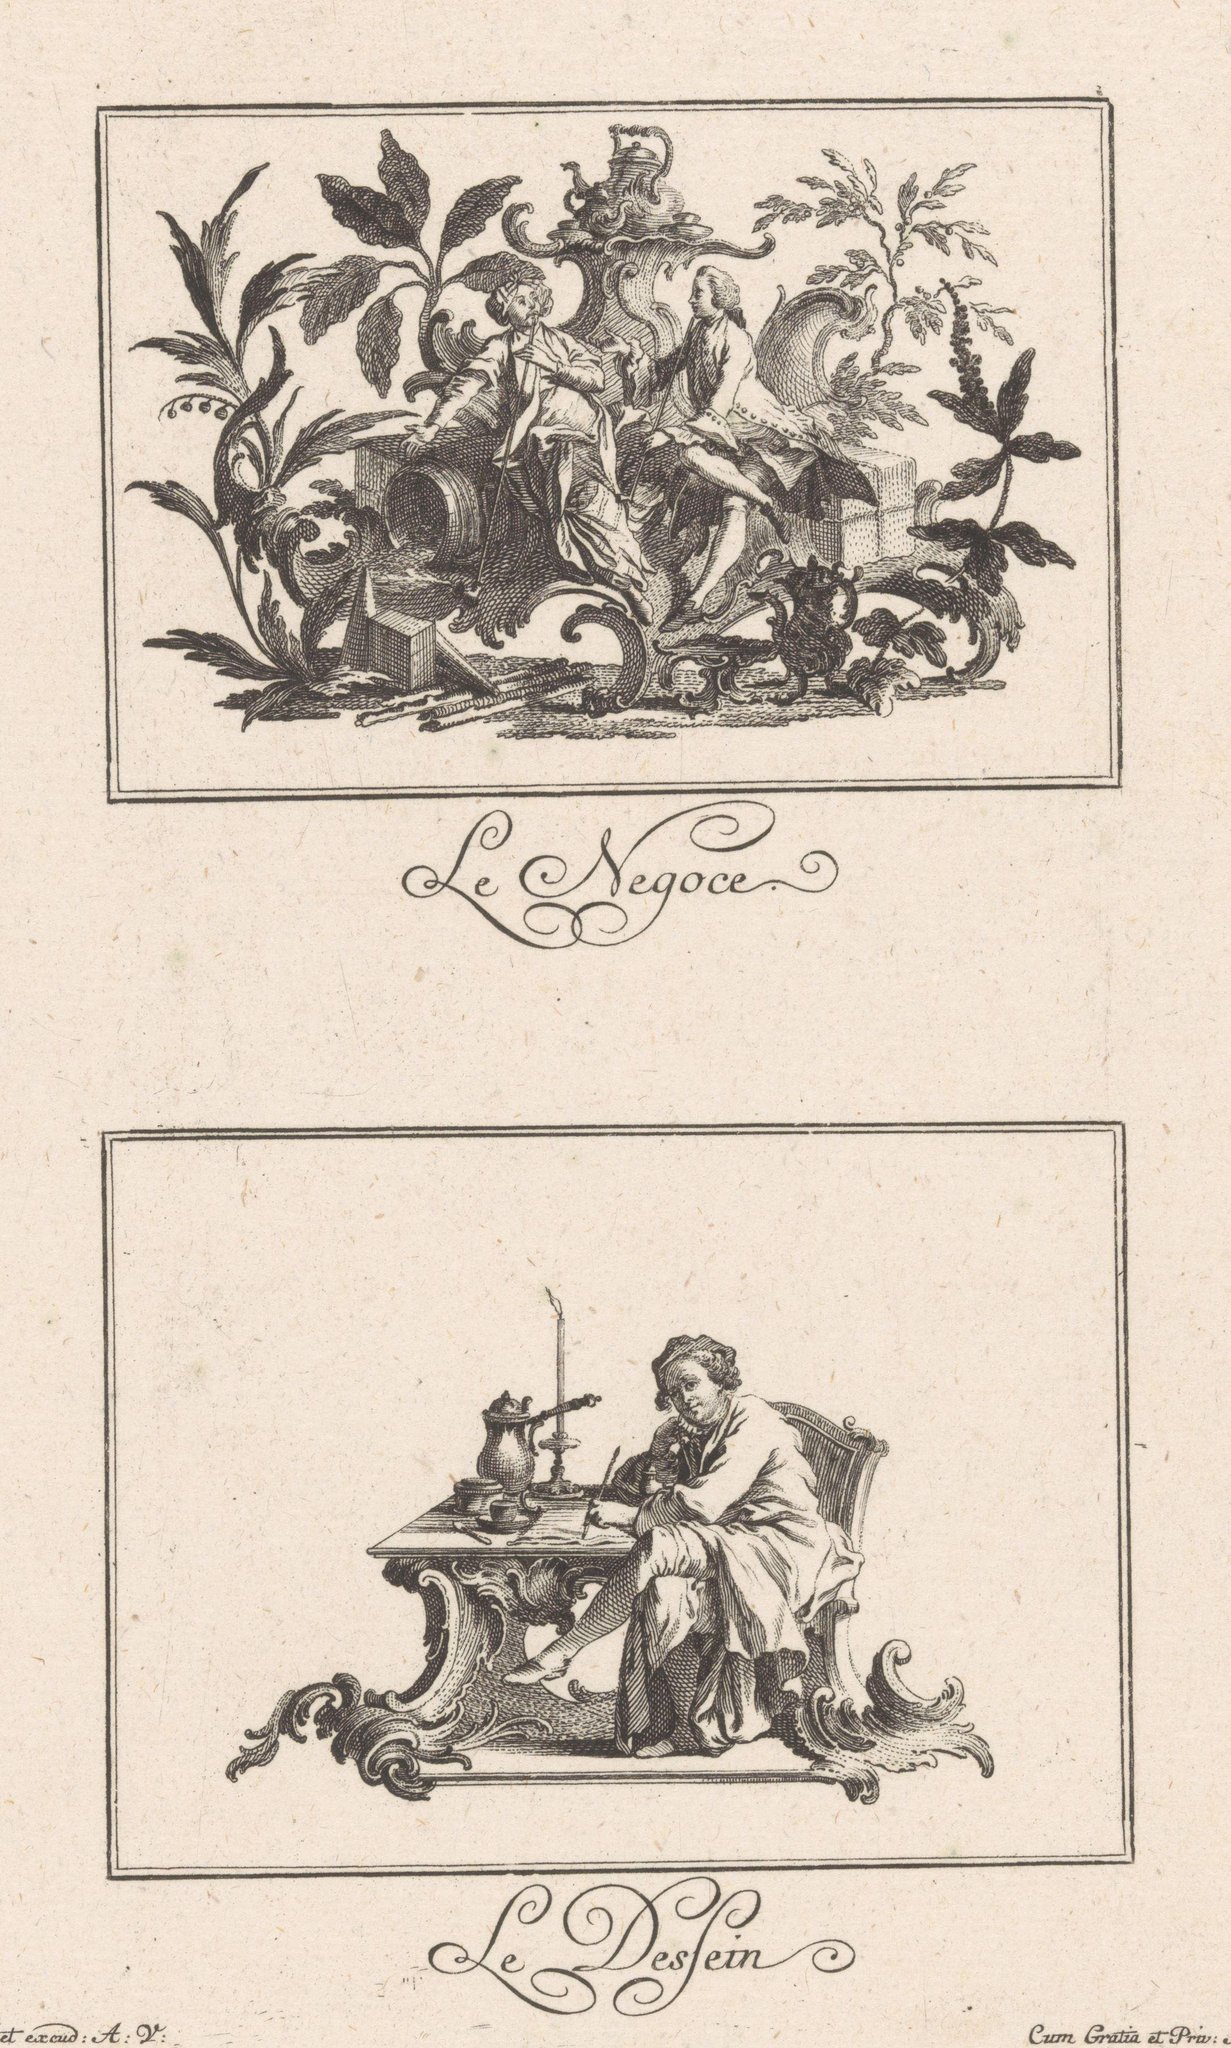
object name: ornament print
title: La Negoce, Le Dessein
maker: johann esaias nilson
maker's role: draughtsman, print maker, publisher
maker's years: 1721-1788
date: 1766-1788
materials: paper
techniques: etching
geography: augsburg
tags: draughtsman at work, conversation, dialogue; conversation piece, allegory of trade; 'commertio della vita humana' (ripa), symbolic representations, allegories and emblems ~ drawing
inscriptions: collector's mark: Lugt 2760, collector's mark: Lugt 2228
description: Twee scènes met rocaille ornamenten op een blad. Boven: Een westerse en Turkse man zitten in een fantasielandschap met een vat, een pakket en een theeservies te roken. Onder: Een man zit aan een geornamenteerde tafel met koffieservies en kandelaar te tekenen.